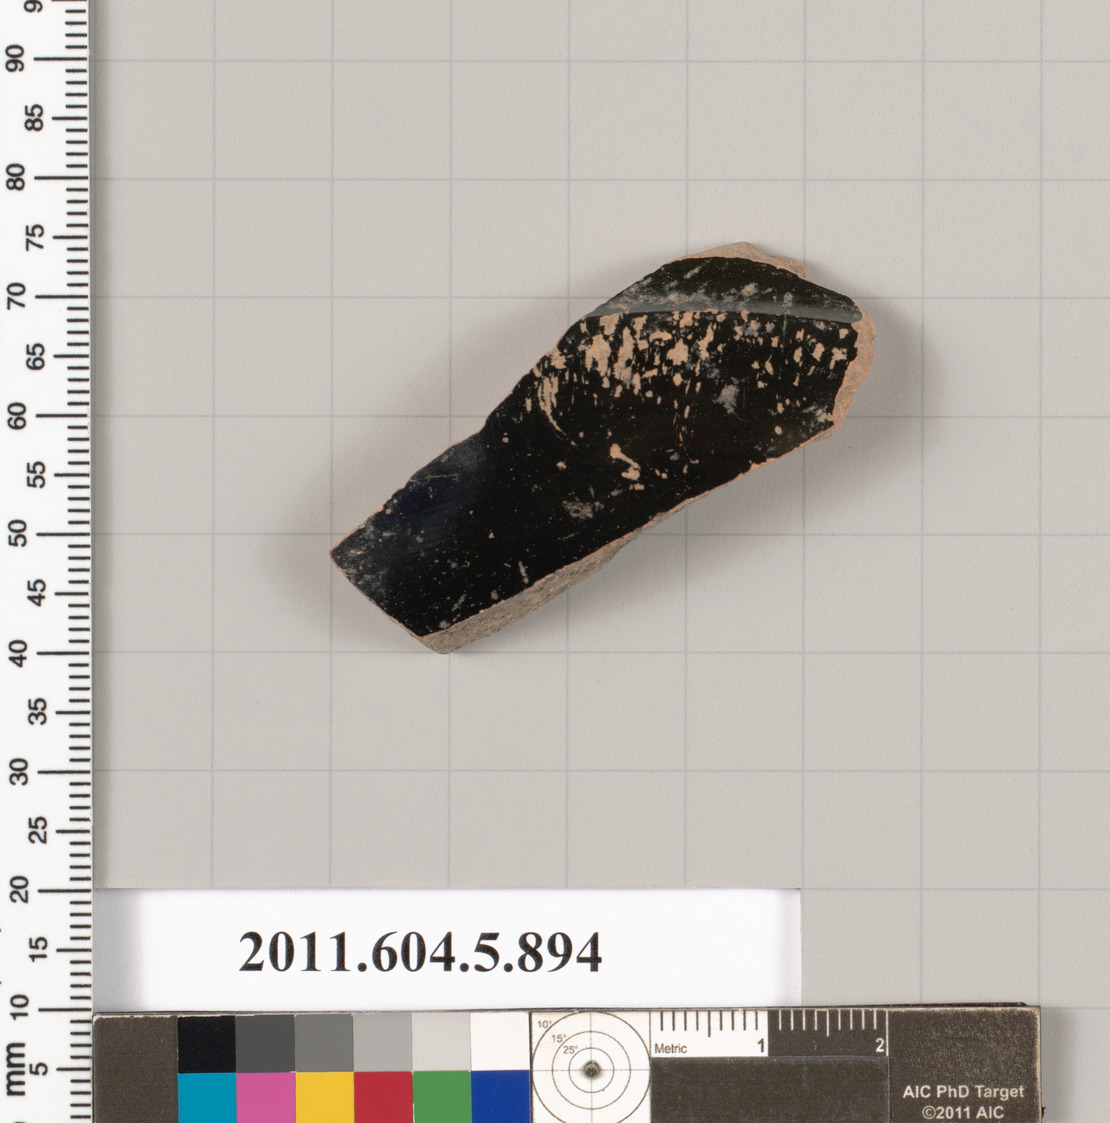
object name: kylix fragment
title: Terracotta fragment of a kylix (drinking cup)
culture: greek, attic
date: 600-401 BCE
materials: terracotta